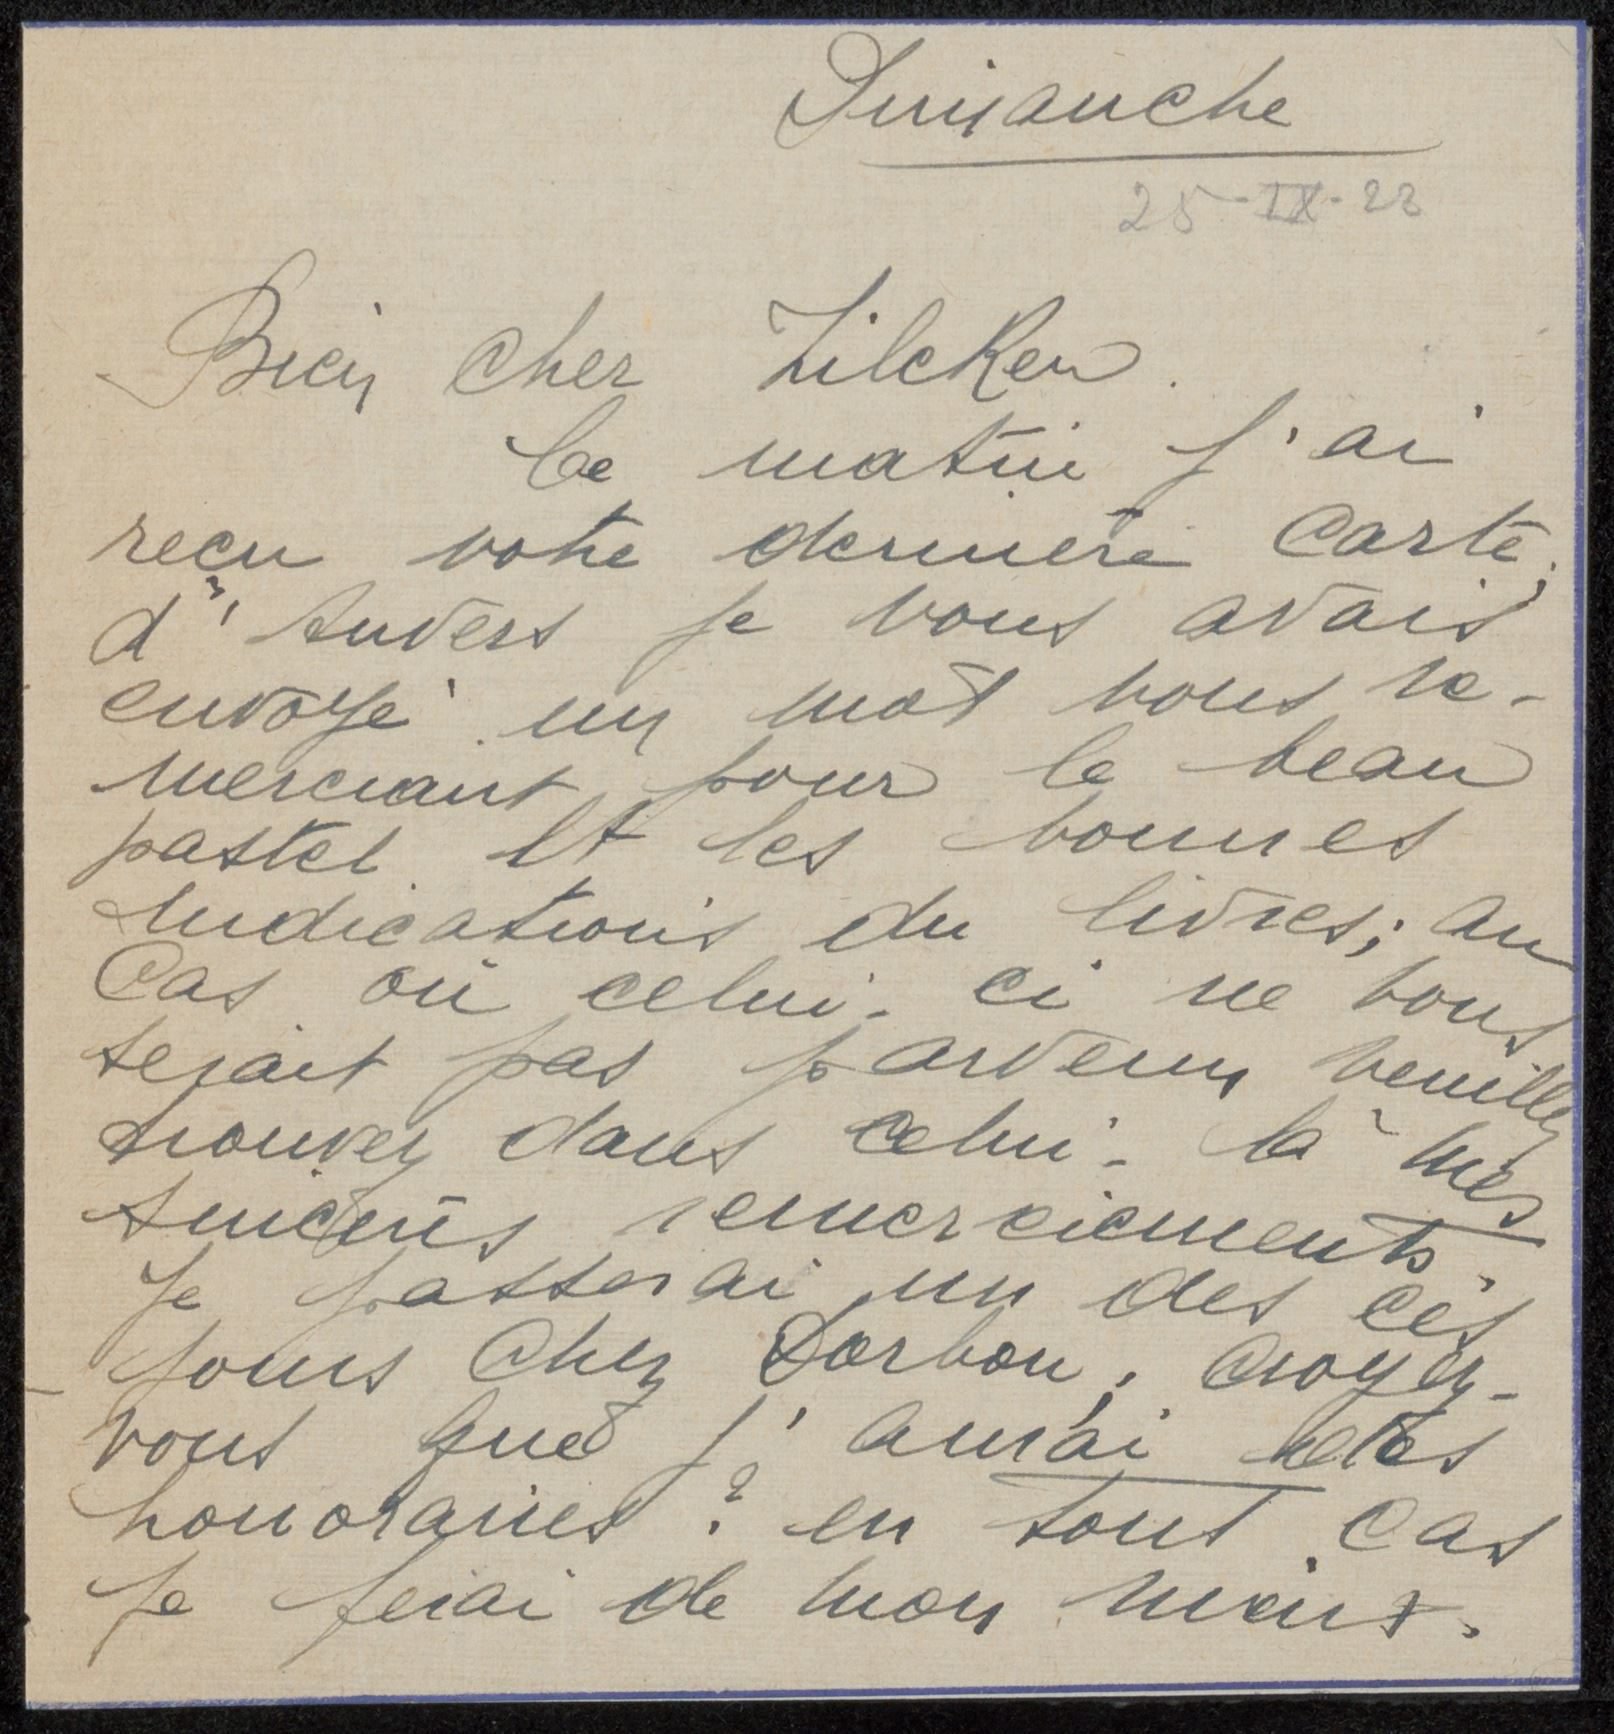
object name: letter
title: Brief aan Philip Zilcken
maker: rose imel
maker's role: draughtsman, painter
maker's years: 1901-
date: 1911-1930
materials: ink, paper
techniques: pen, writing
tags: the hague, painter, draughtsman, philip zilcken, the graphic arts, antwerp, paris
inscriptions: collector's mark: ‘RPK’